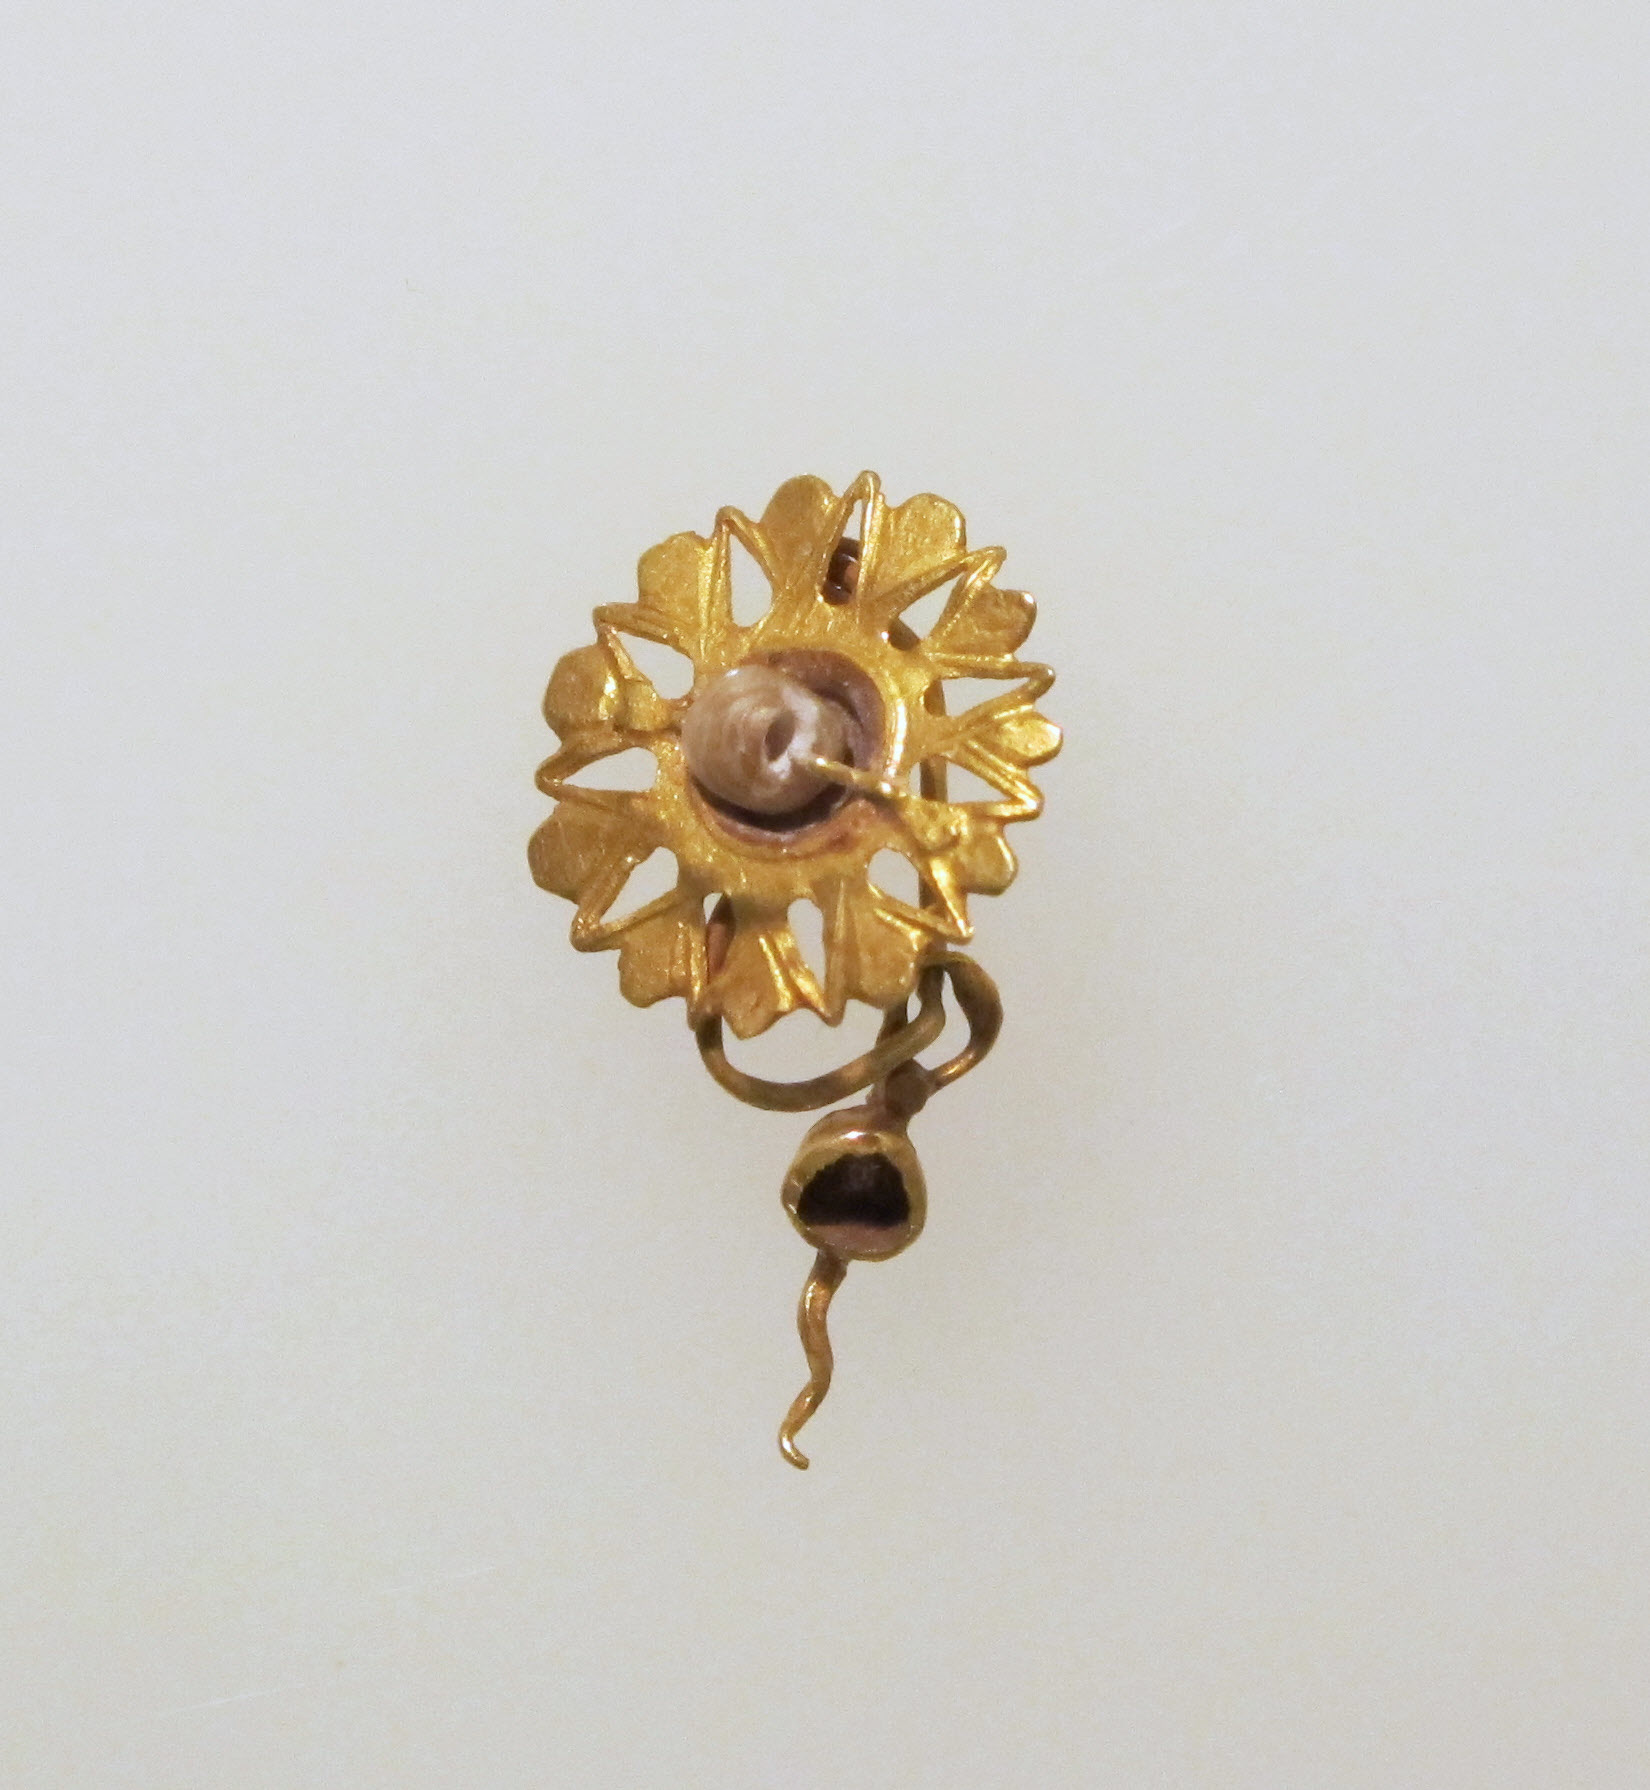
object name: earring with pendant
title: Earring with pendant and disc and pearl setting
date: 7000 BCE-330 CE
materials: gold, pearl